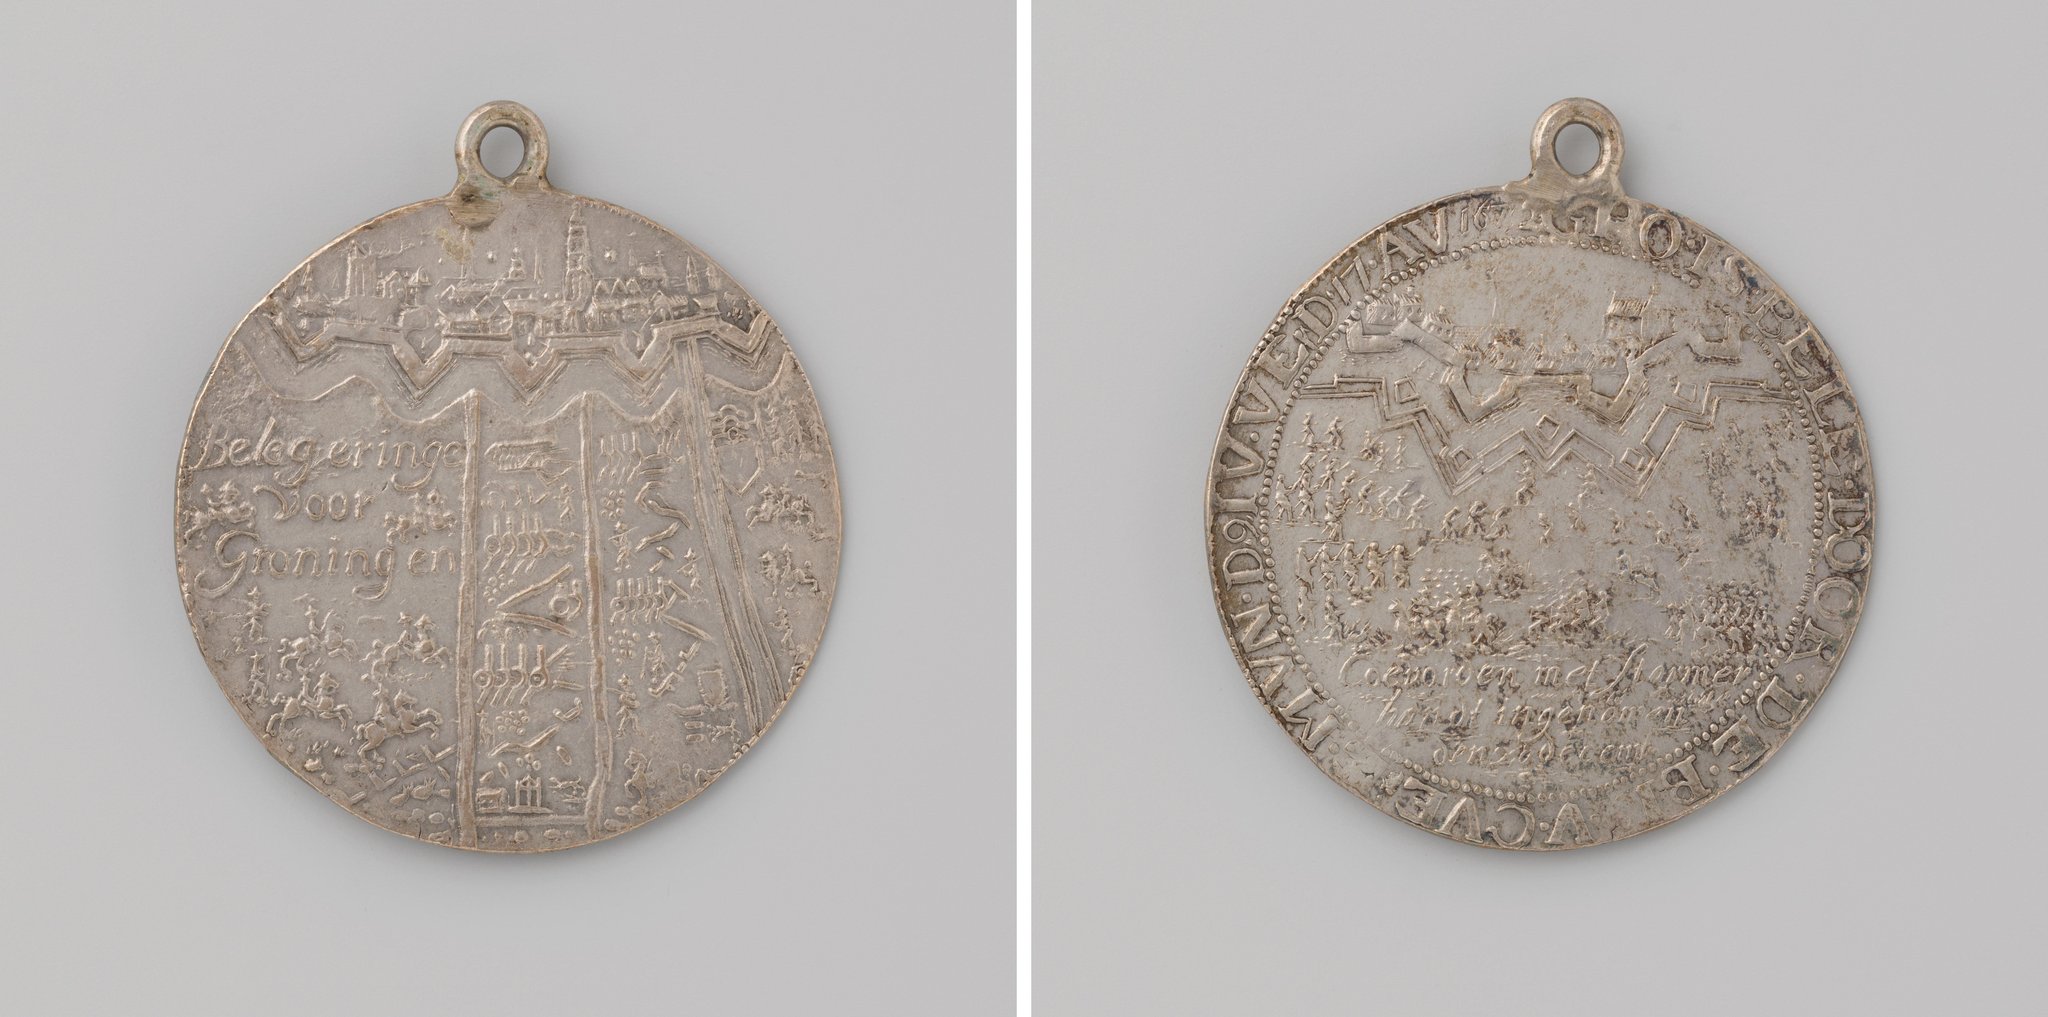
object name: history medal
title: Beleg van Groningen en inname van Coevorden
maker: Anonymous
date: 1672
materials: silver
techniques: striking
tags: rampjaar (disaster year)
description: Zilveren penning. Voorzijde: gezicht op stad en belegeraars tijdens beschieting met links midden opschrift. Keerzijde: stad met belegeraars boven opschrift en binnen omschrift.